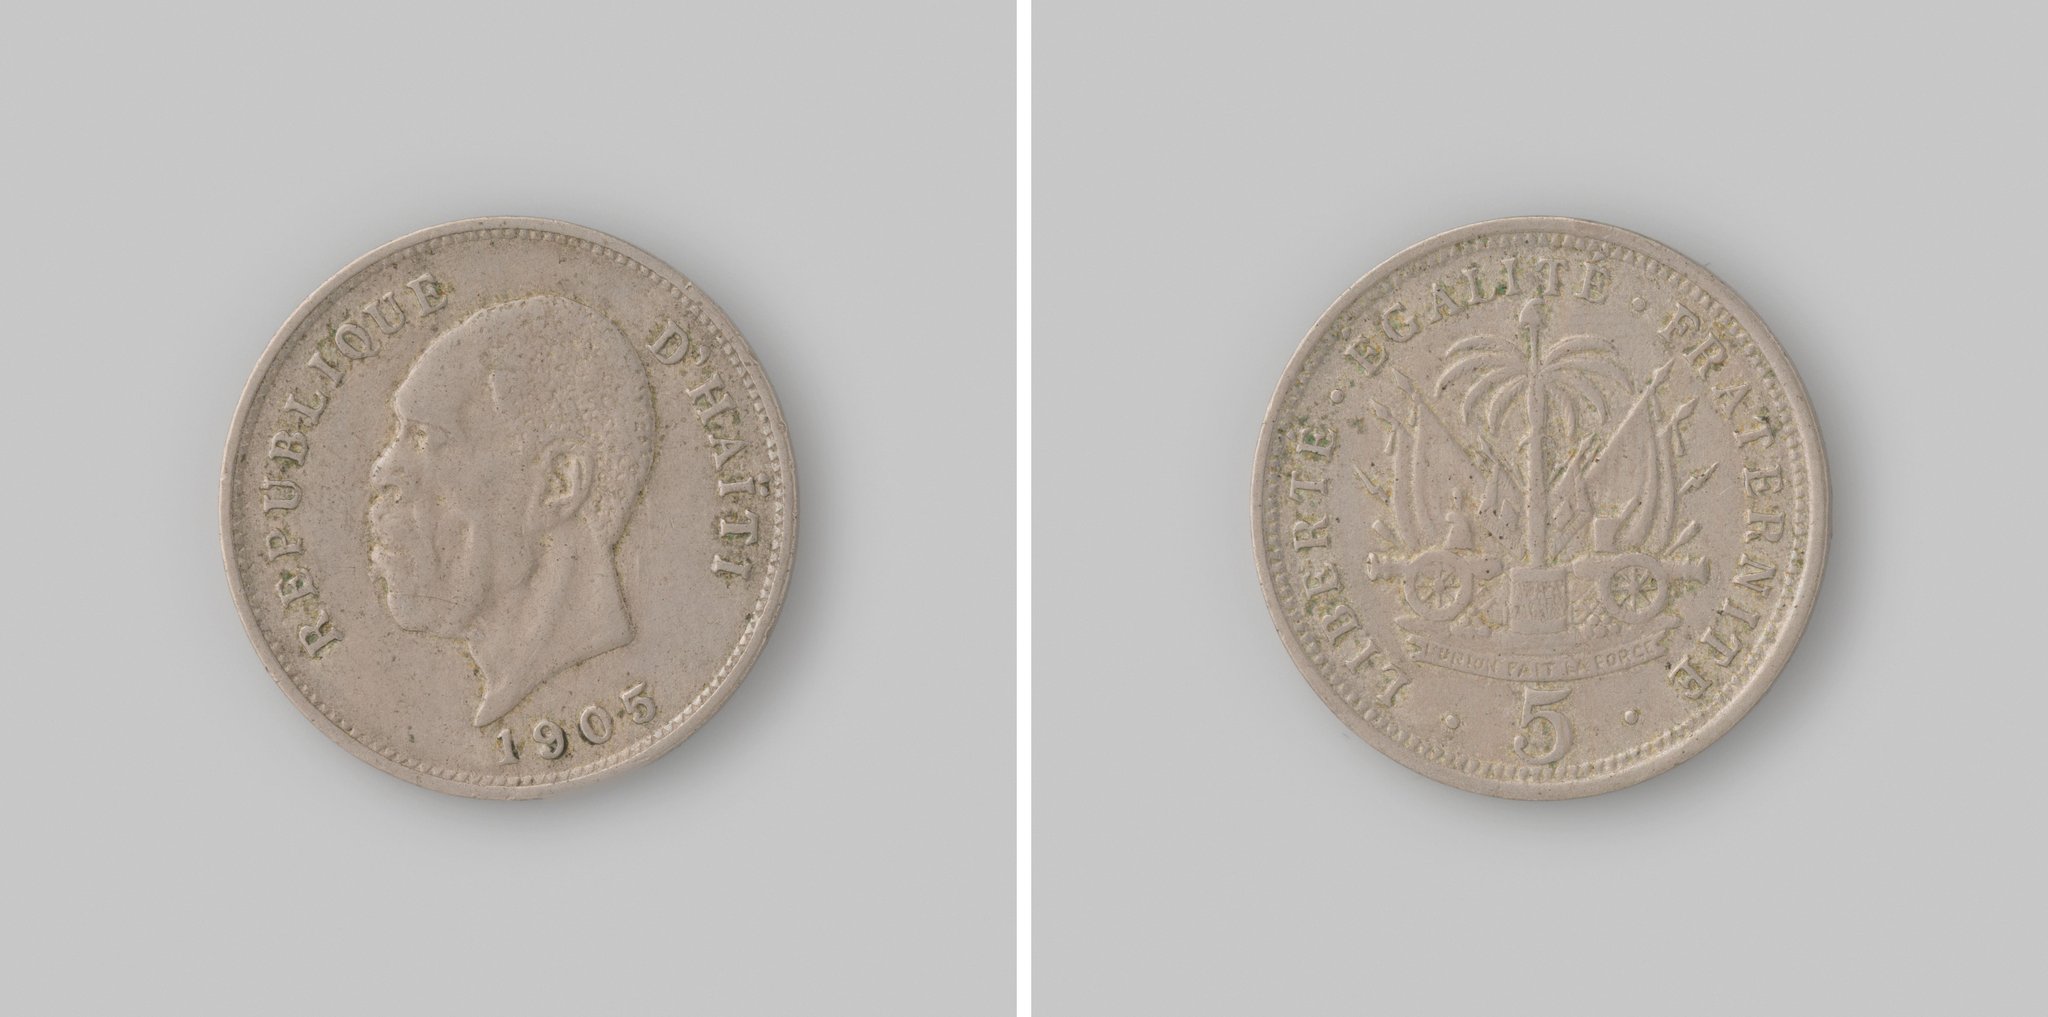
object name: coin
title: 5 centimes uit Haïti, 1905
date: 1905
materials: nickel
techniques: striking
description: Koper-nikkelen munt. Voorzijde: hoofd van de president naar links. Daaronder jaartal. Keerzijde: uit trommel oprijzende palmboom, waarachter banieren. links en rechts van trommel twee kanonnen, waaronder stapel kogels. Daaronder banderol met spreuk. Onderaan waarde-aanduiding: 5. Gladde rand.